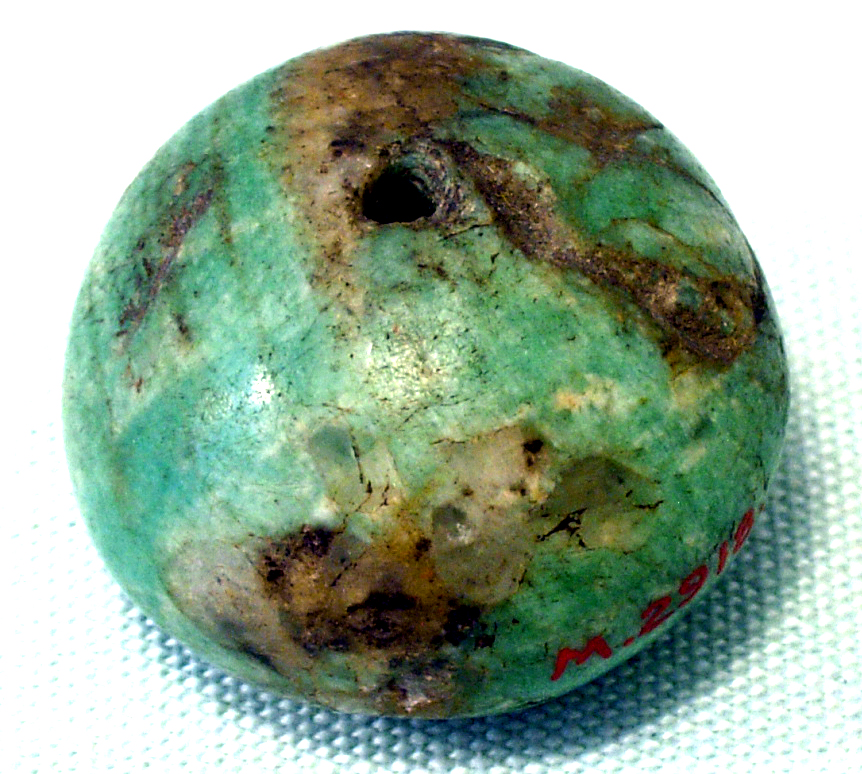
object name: bead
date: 801-1900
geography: egypt